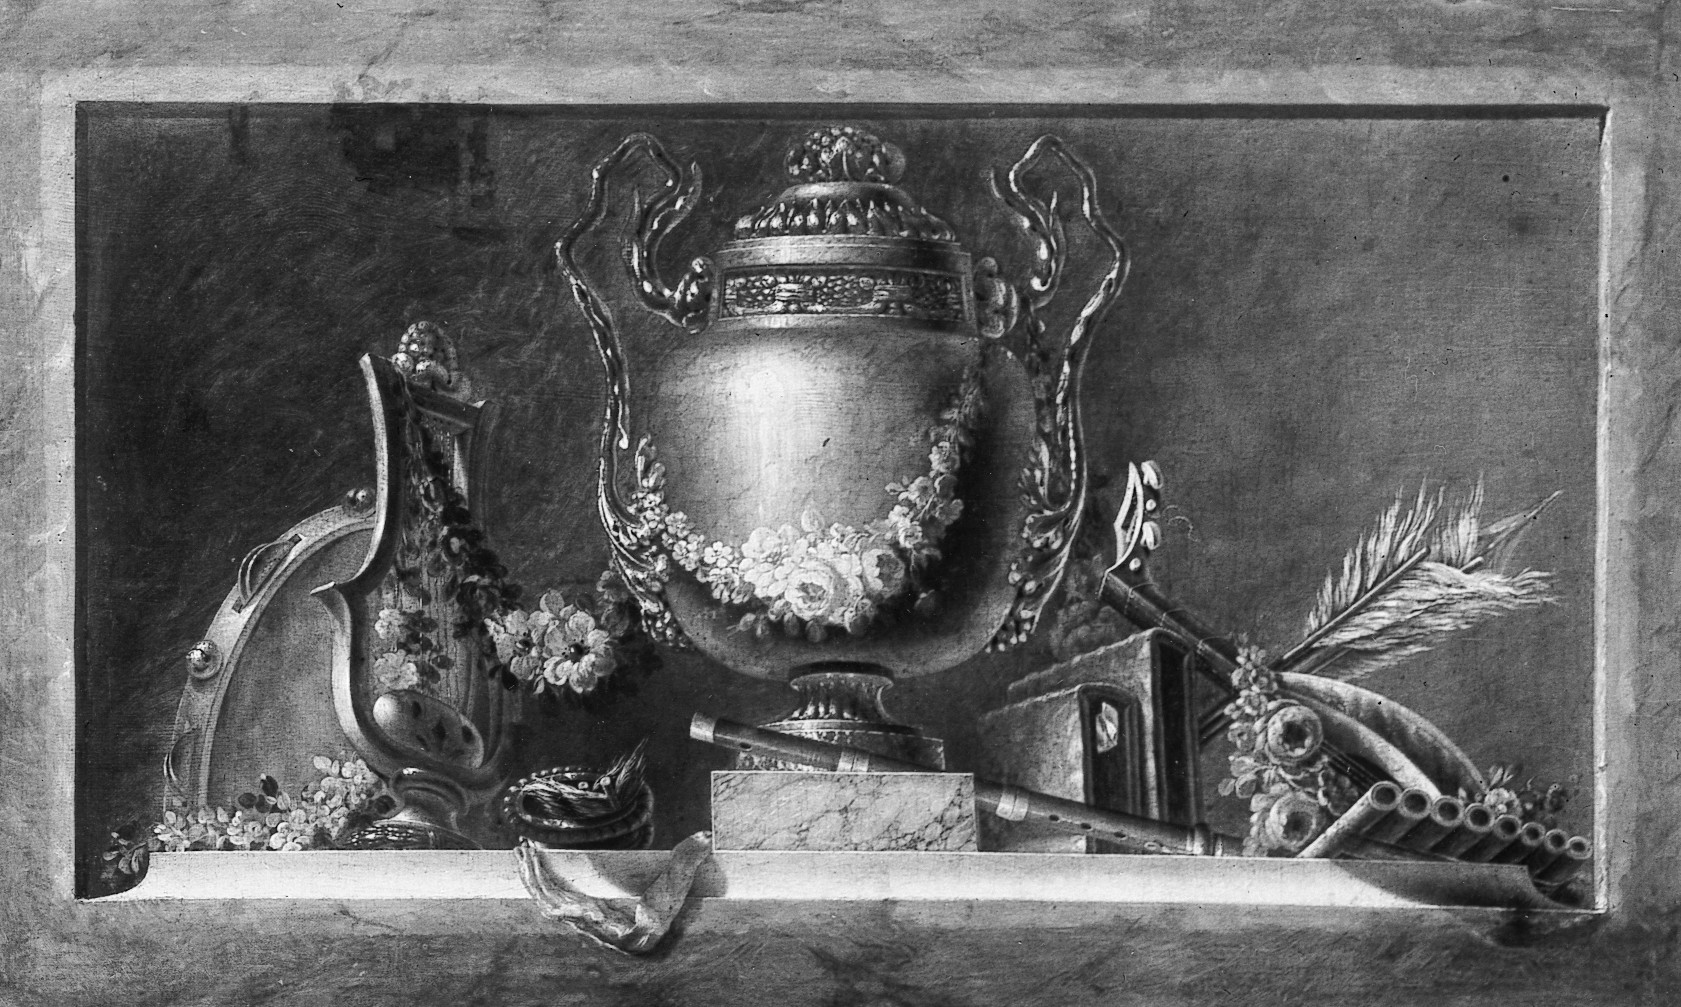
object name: overdoor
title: Still life with musical instruments (one of a pair)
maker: french painter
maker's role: artist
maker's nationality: french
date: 1701-1800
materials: canvas, oil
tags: musical instruments,garlands,still life